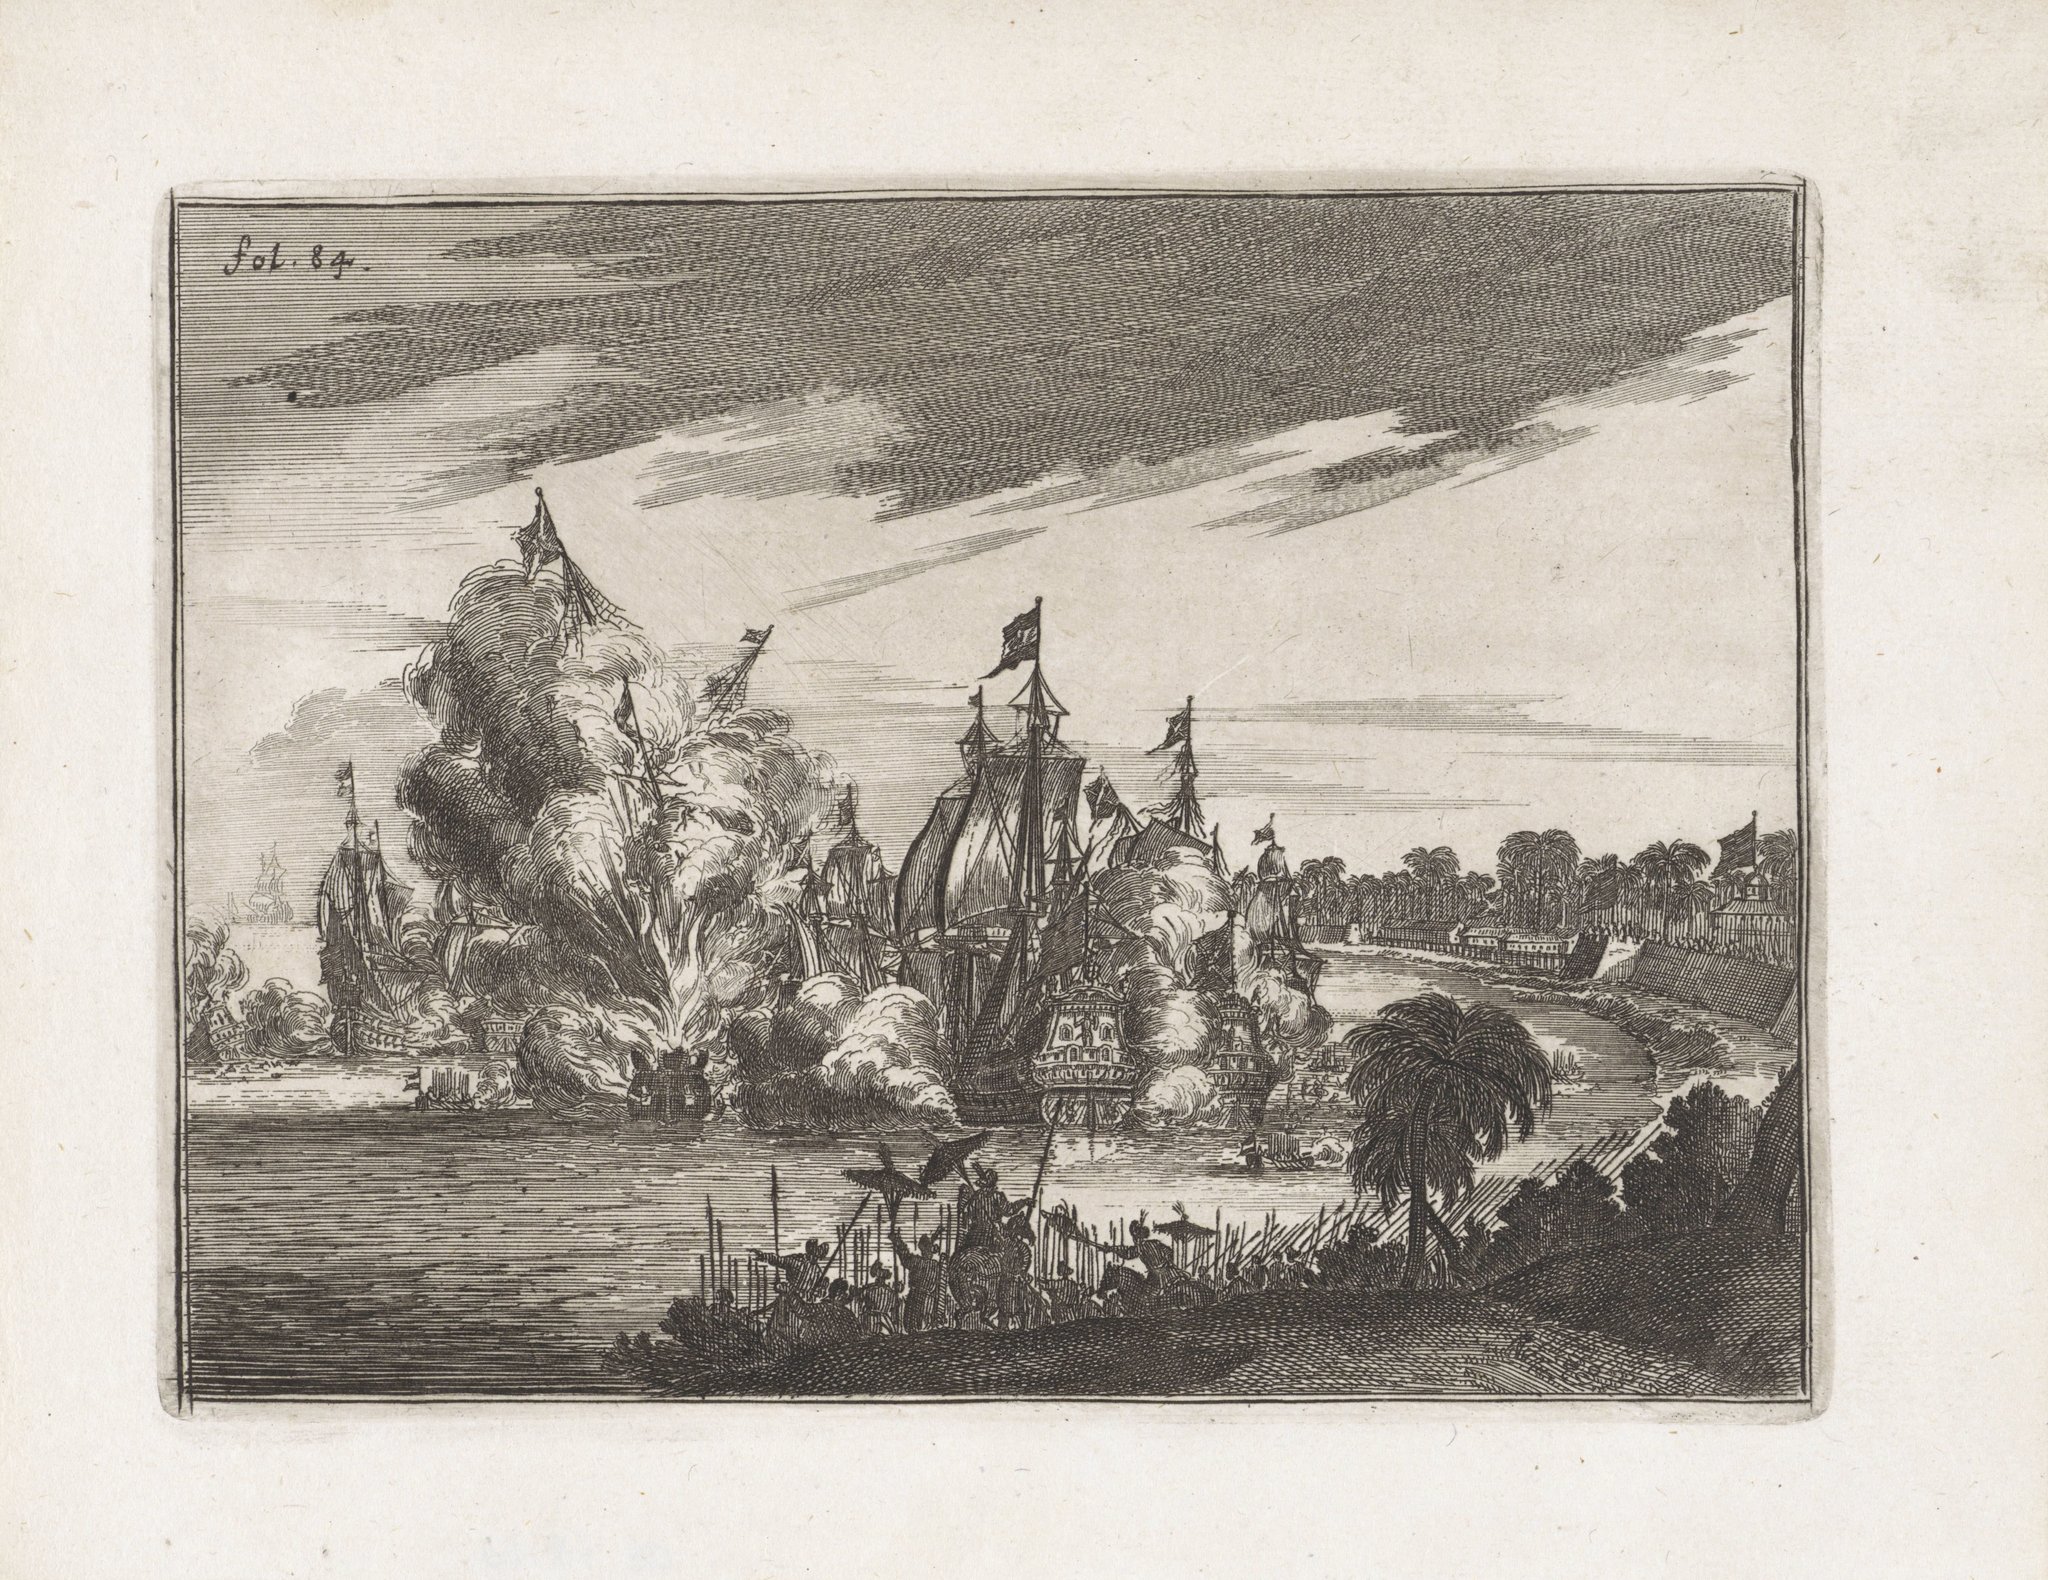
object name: book illustration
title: Zeeslag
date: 1676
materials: paper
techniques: etching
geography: low countries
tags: battle (+ sailing-ships)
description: De prent is als boekillustratie gebruikt in: Schouten, Wouter. Oost-Indische voyagie (...), Amsterdam: Jacob Meurs en Johannes van Someren, 1676.